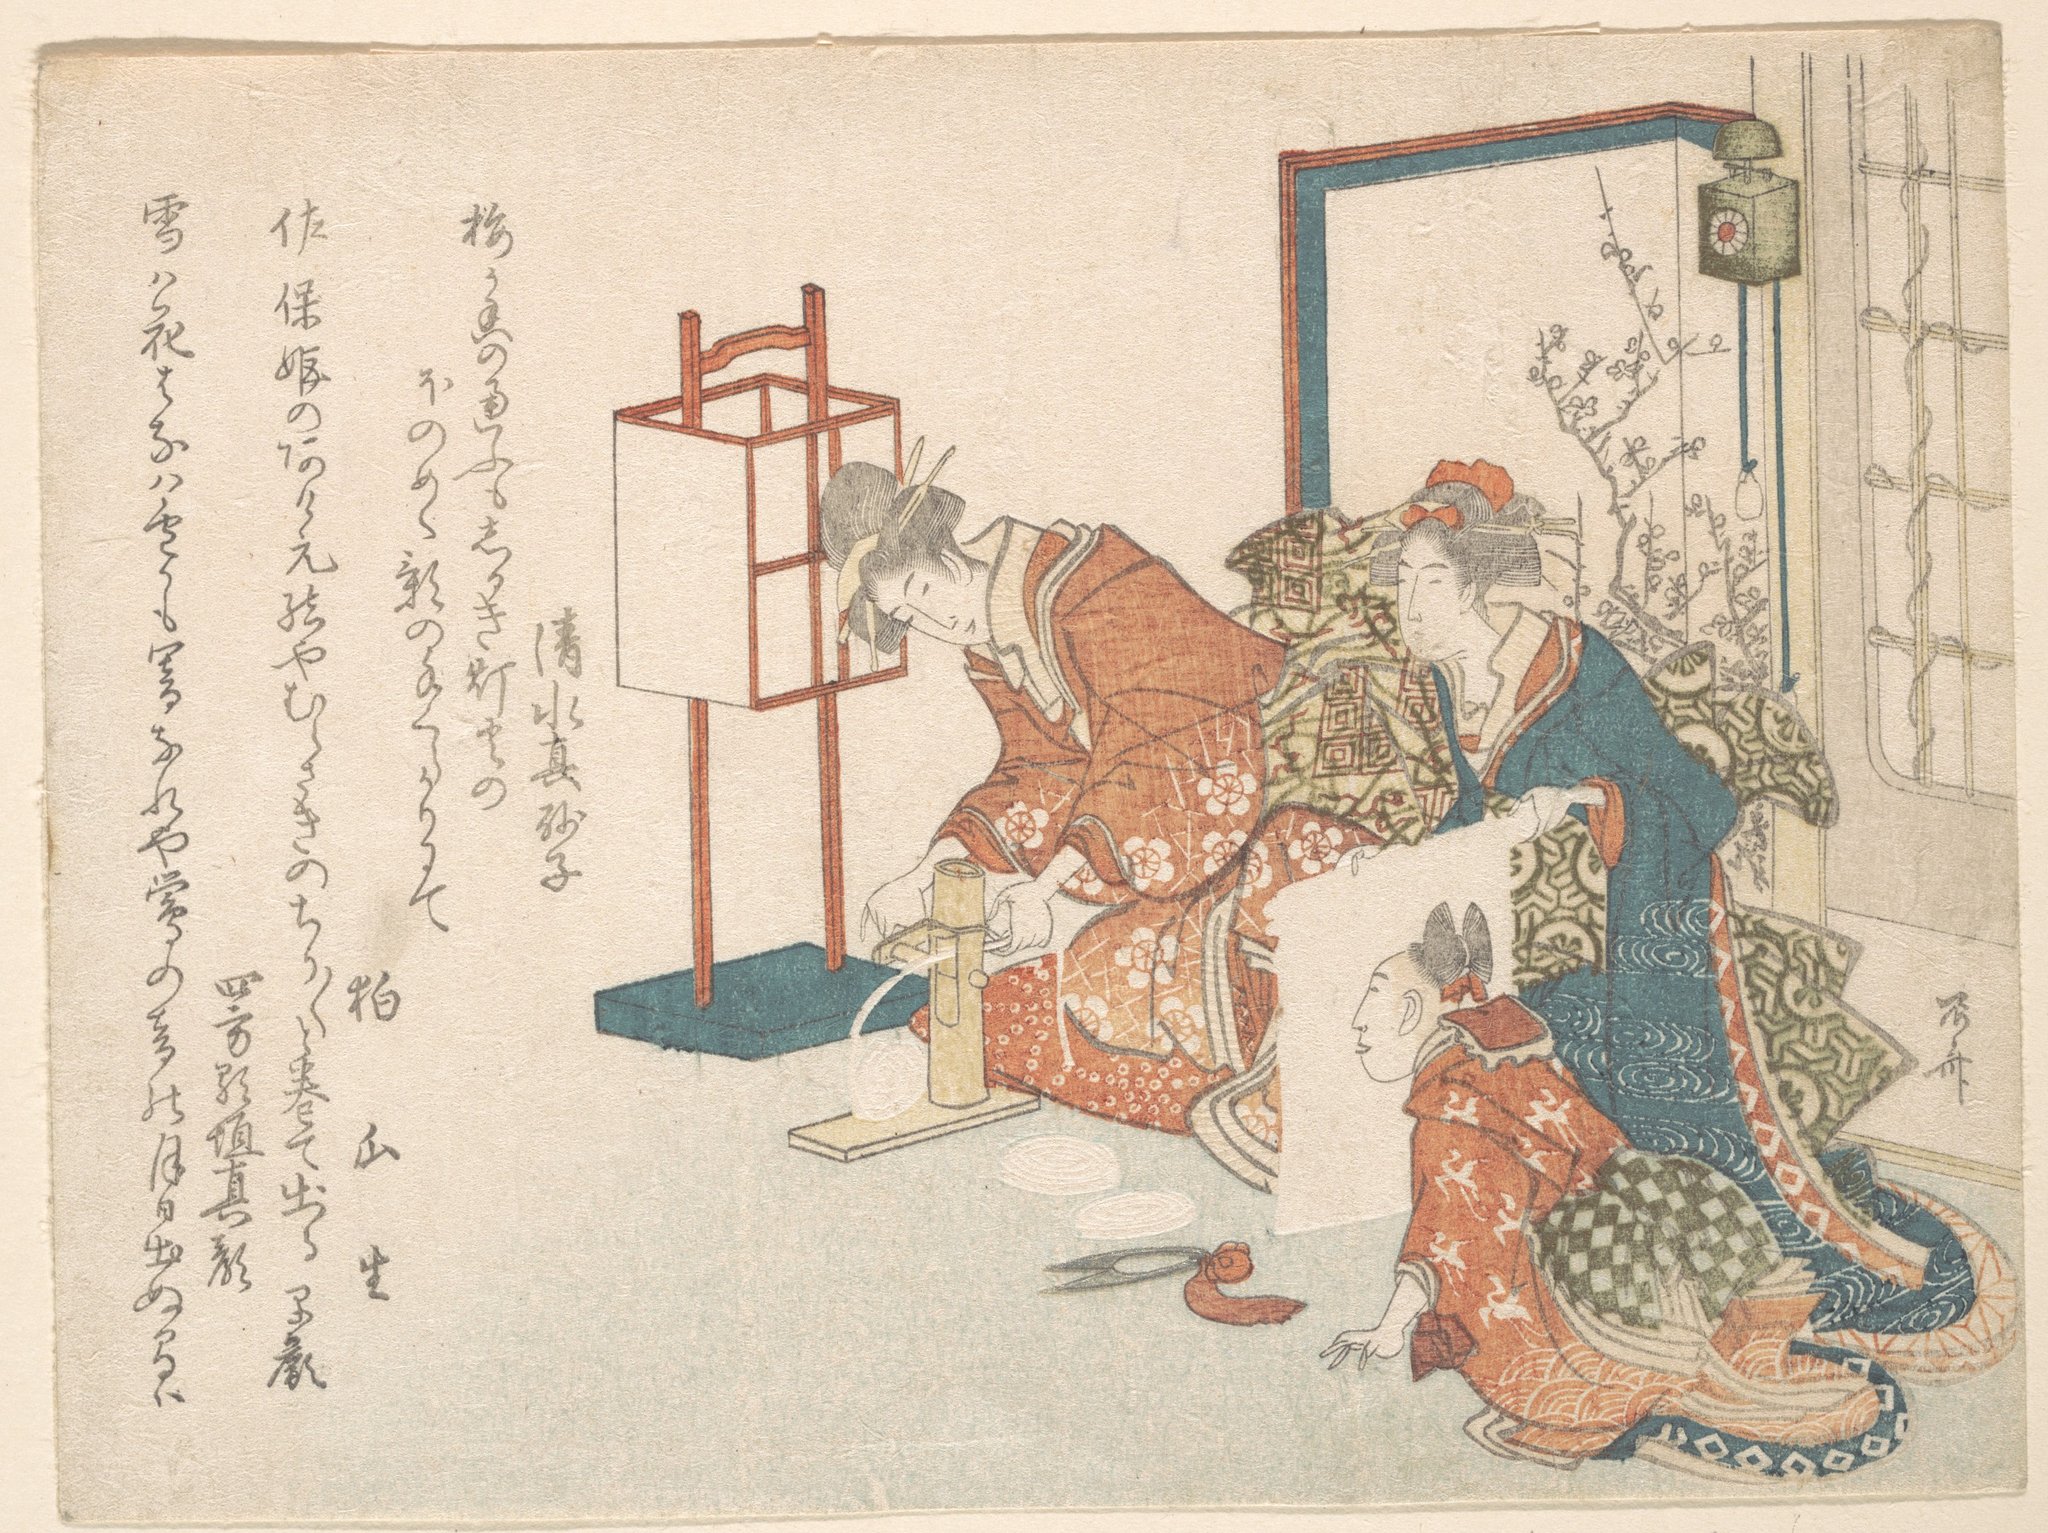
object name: print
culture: japanese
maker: ryūryūkyo shinsai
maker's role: artist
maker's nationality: japanese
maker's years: 1799-1823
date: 1750-1835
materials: ink, paper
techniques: surimono, woodblock print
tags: women